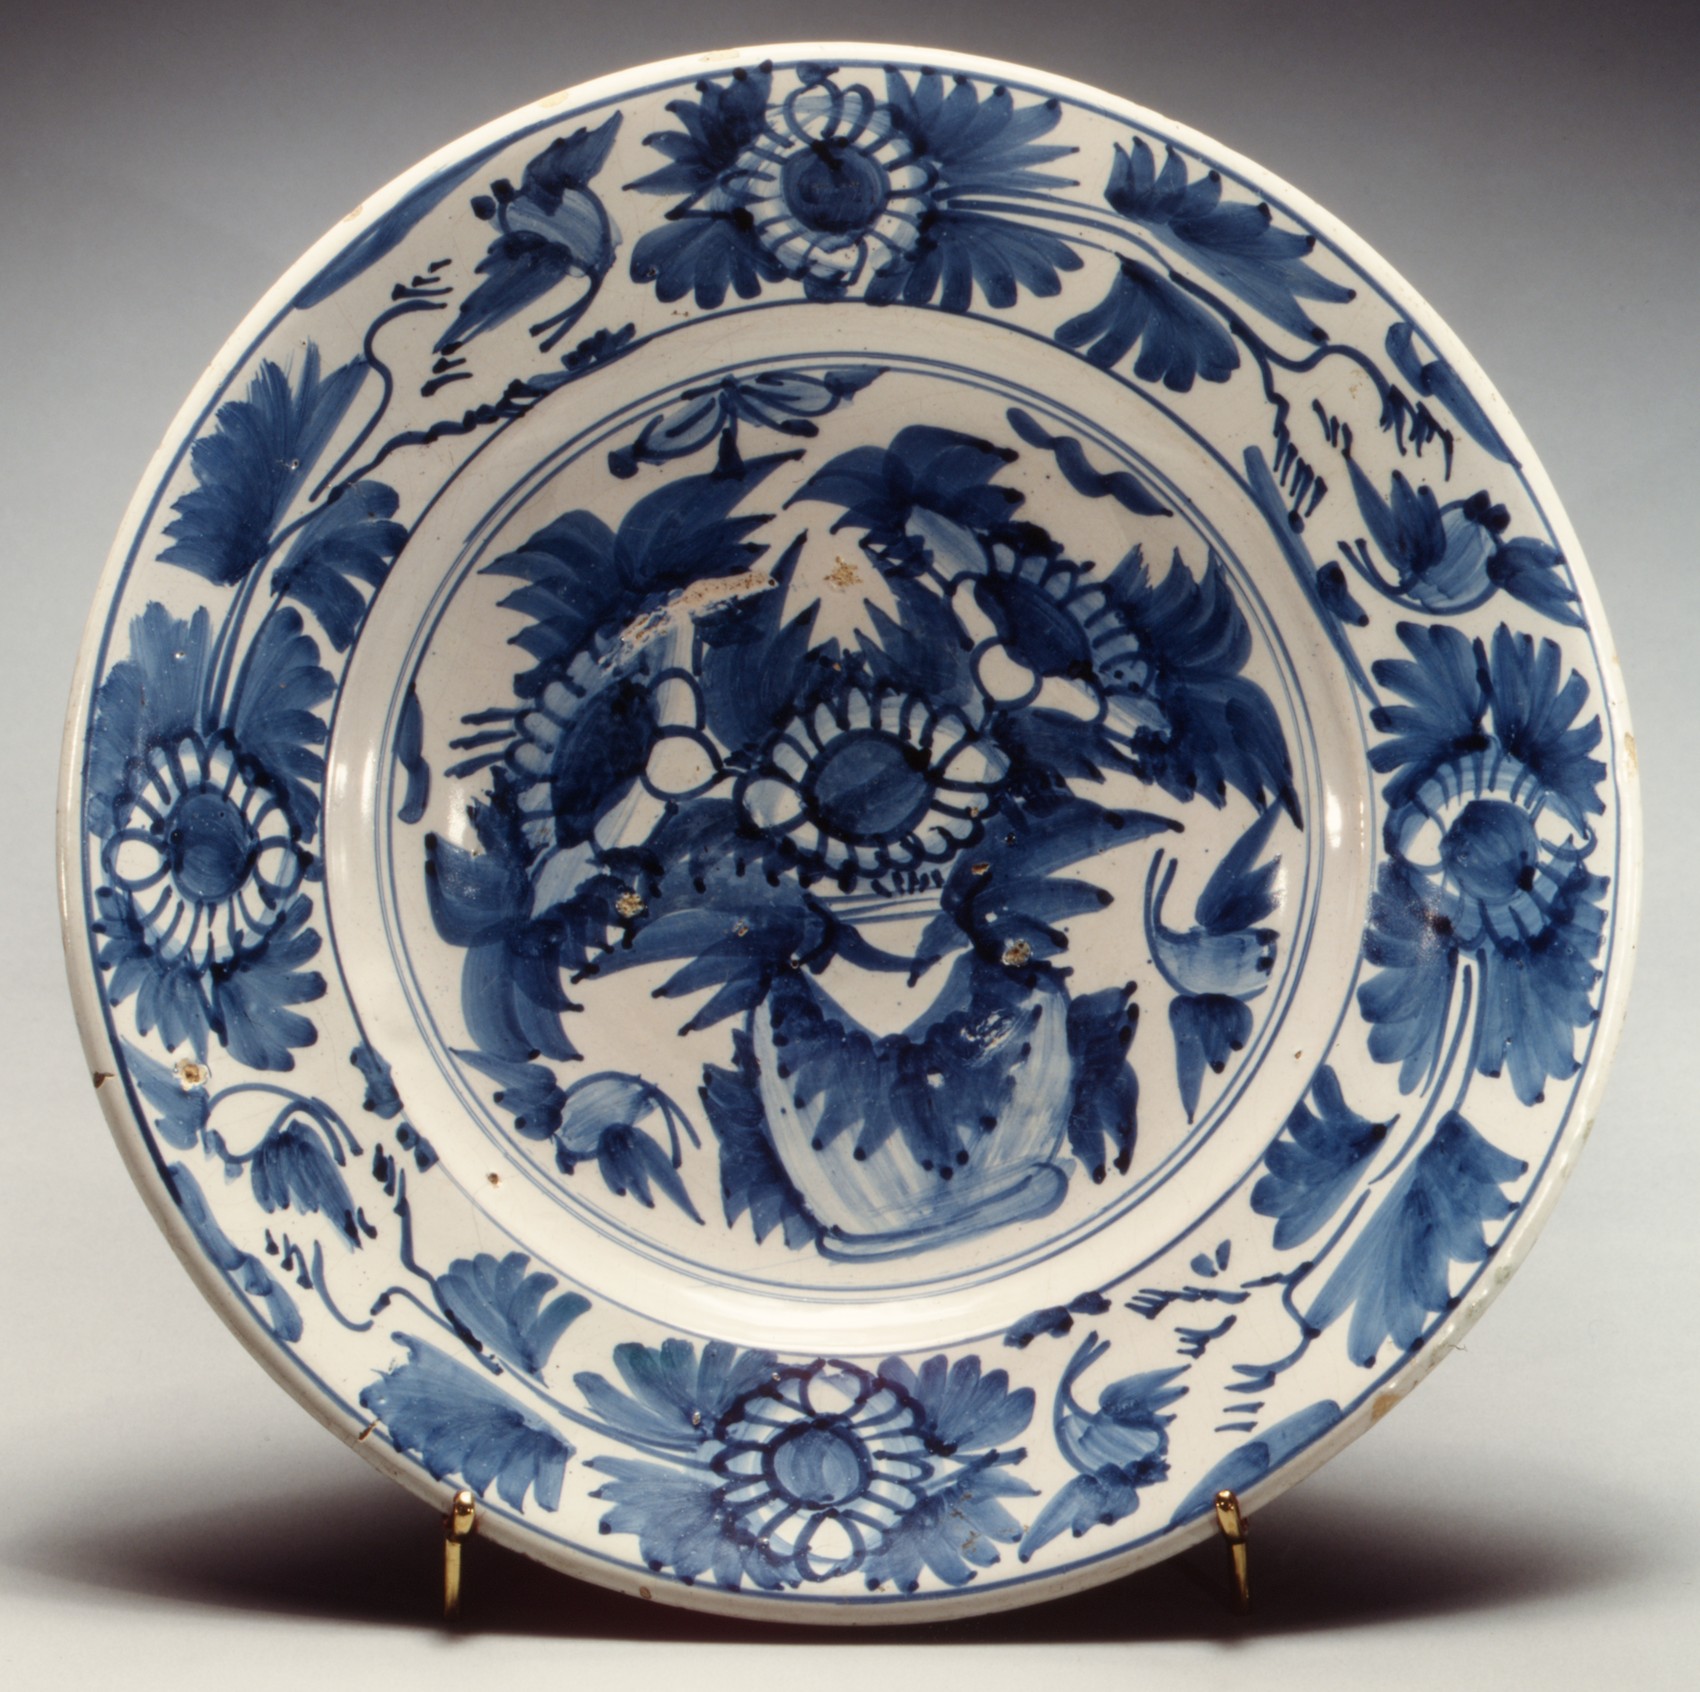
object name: charger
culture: british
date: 1680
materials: earthenware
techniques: glazing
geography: england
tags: flowers